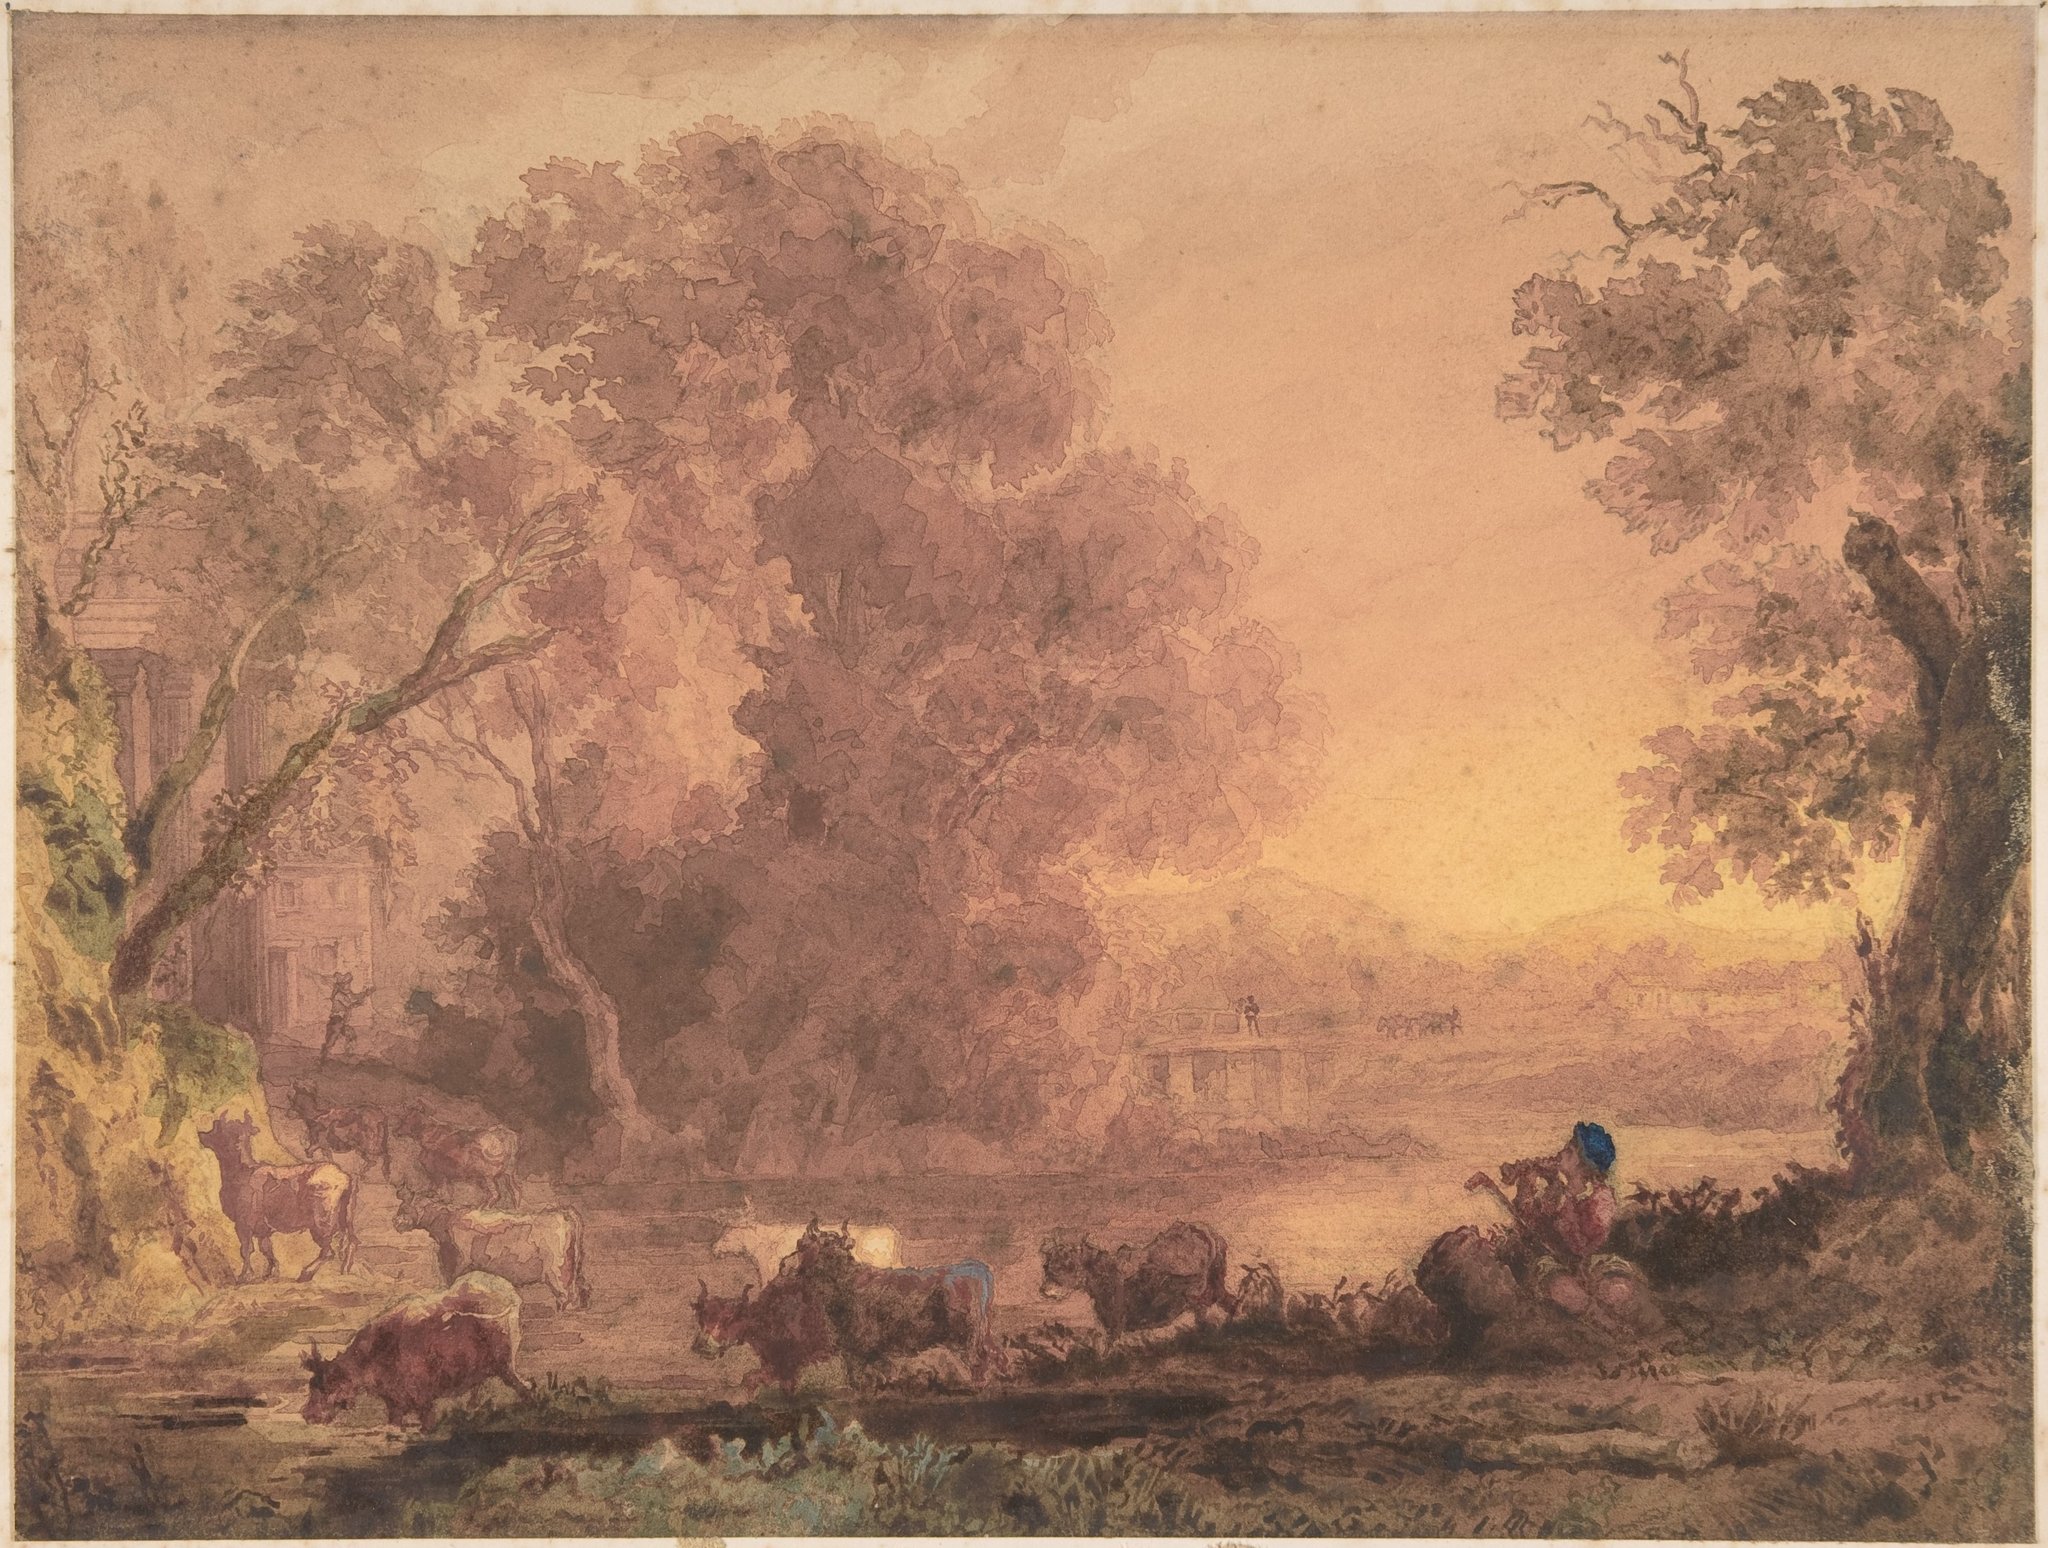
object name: drawing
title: Arcadian landscape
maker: george barret, the younger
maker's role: artist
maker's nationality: british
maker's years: 1767-1842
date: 1820-1842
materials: graphite, watercolor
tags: cows,landscapes